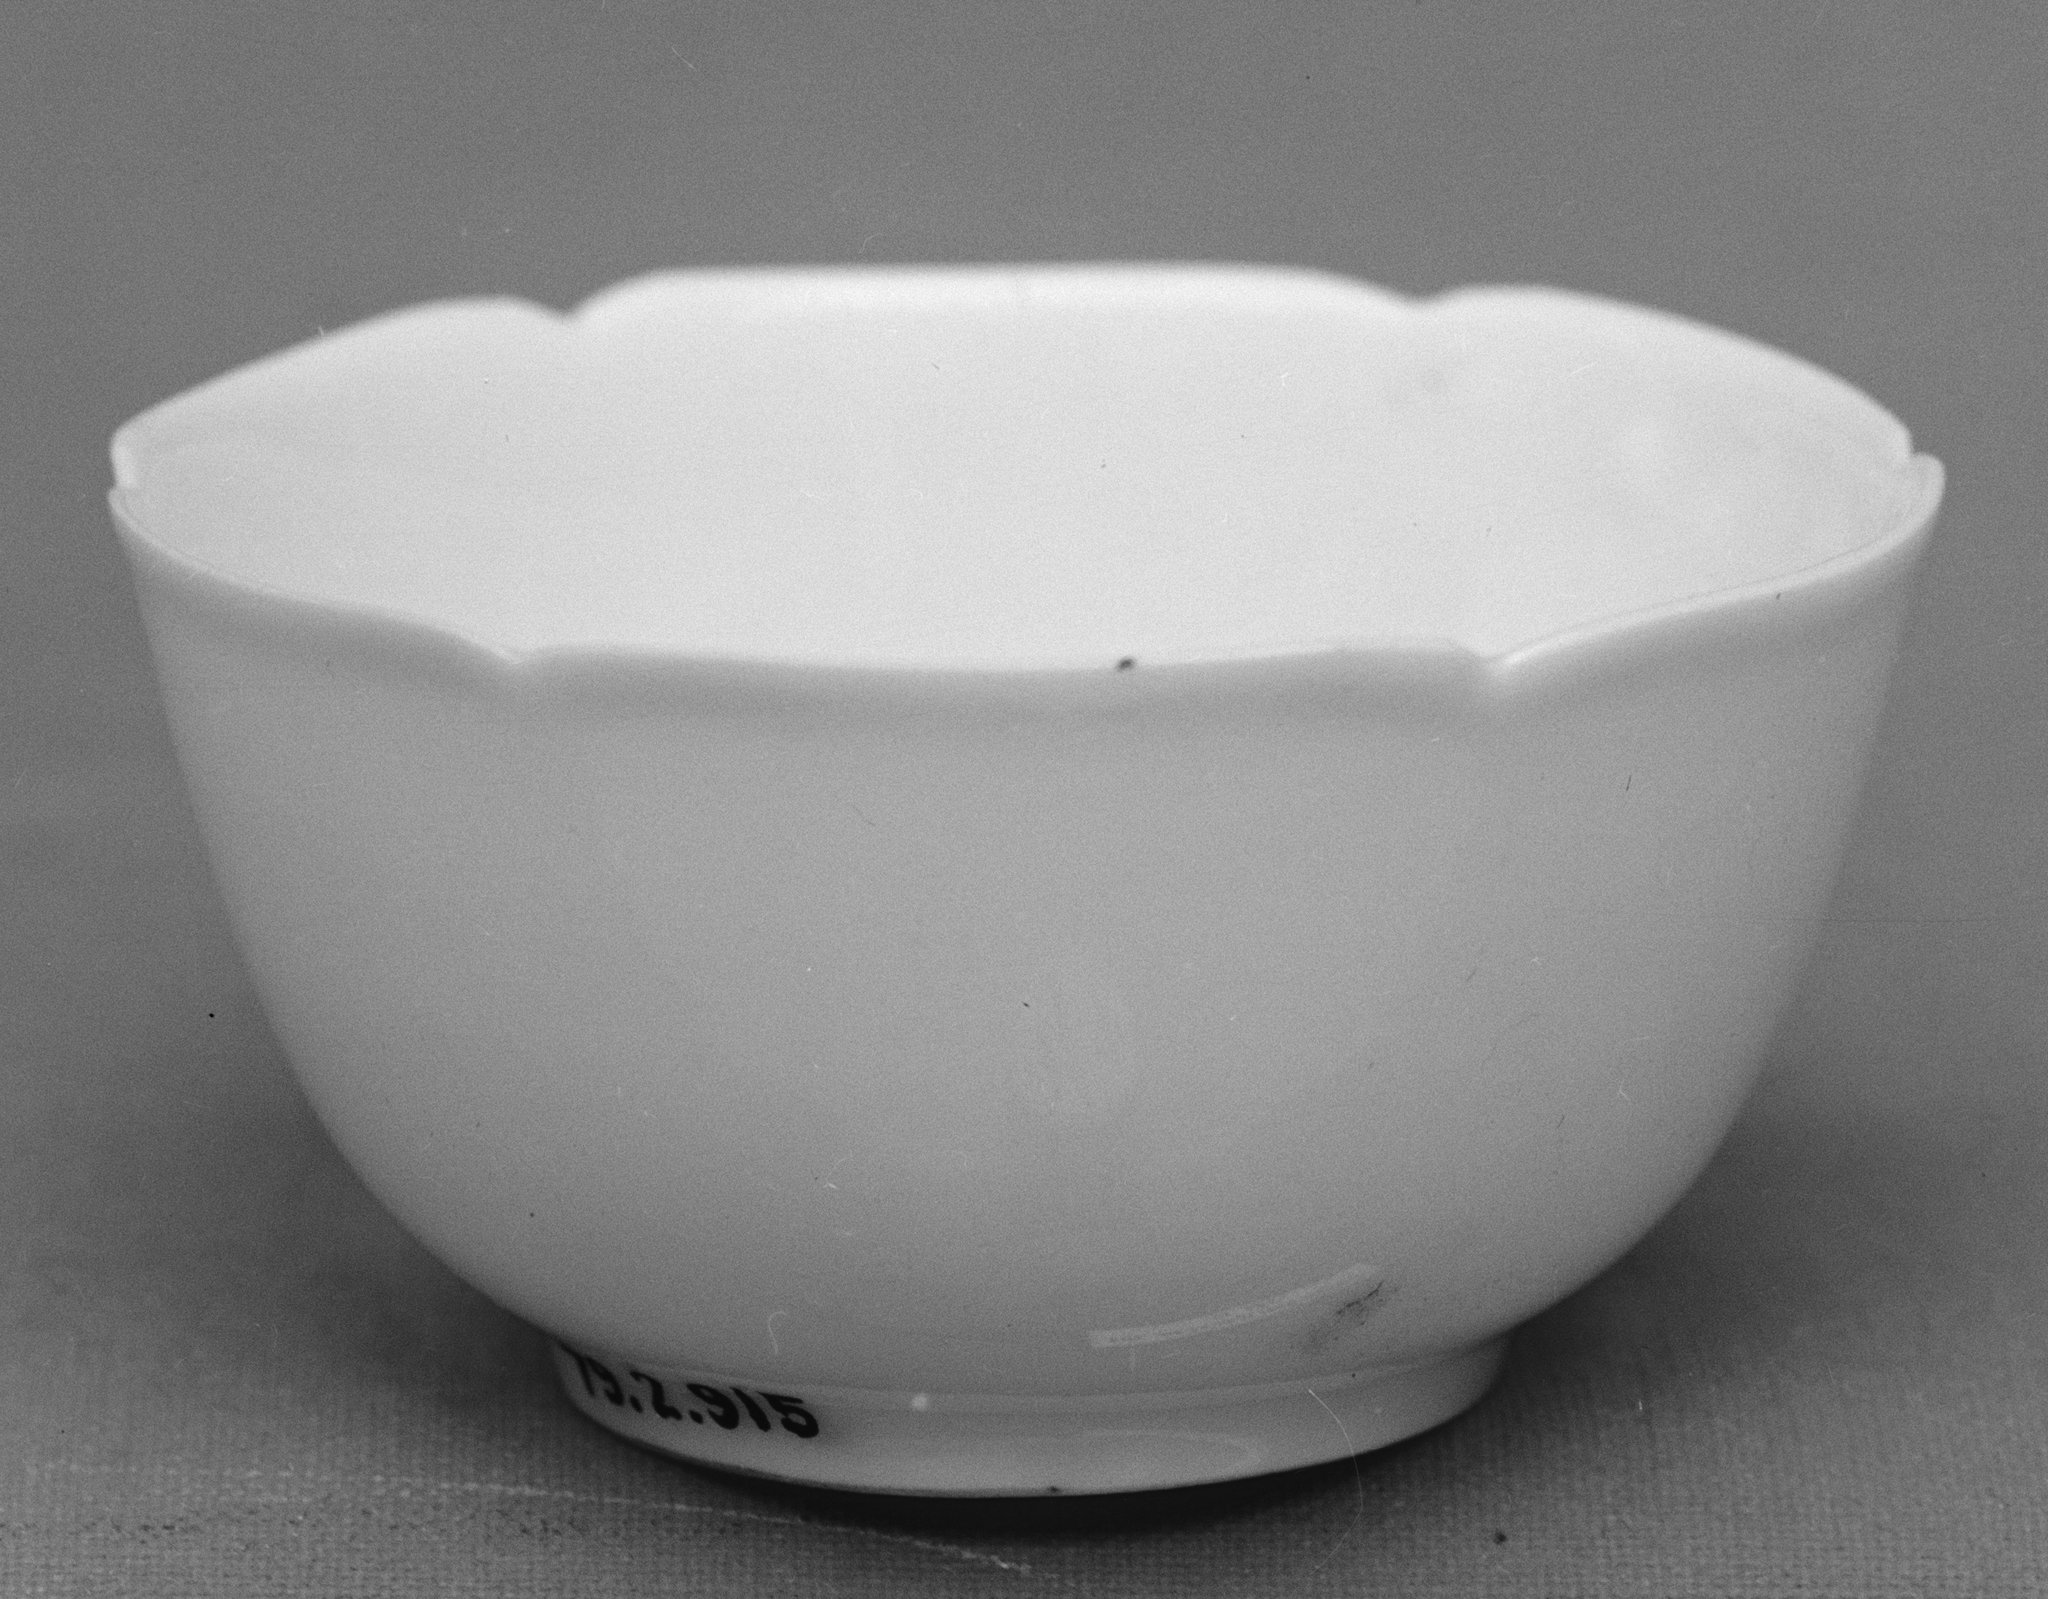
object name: cup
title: Lobed cup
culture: chinese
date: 1701-1800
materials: glaze, porcelain